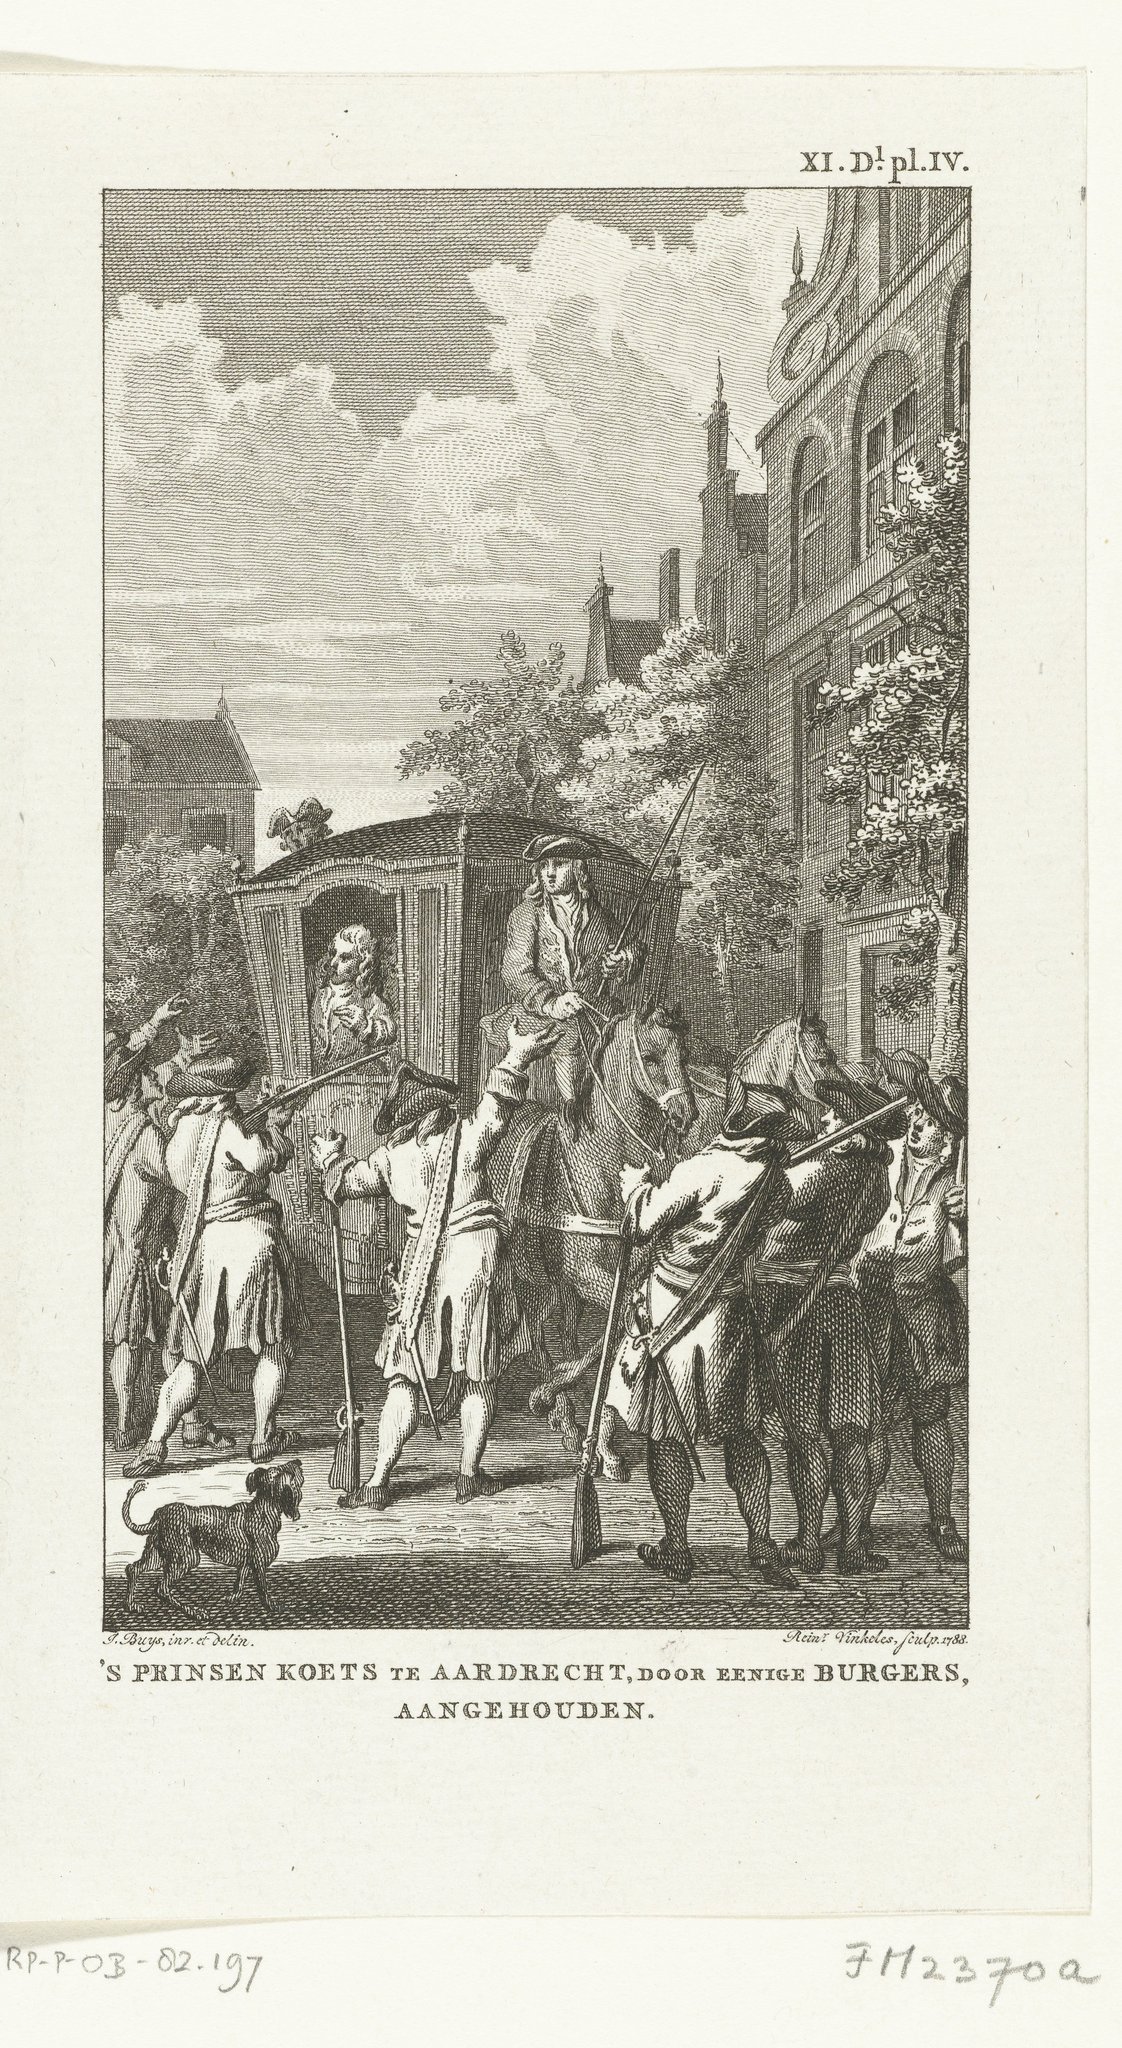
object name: history print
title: De koets van de prins aangehouden door burgers te Dordrecht, 1672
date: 1788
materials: paper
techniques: etching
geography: northern netherlands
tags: the hague, william iii (prince of orange and king of england, scotland, and ireland), dordrecht, rampjaar (disaster year)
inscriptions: date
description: Gebruikt als illustratie in: Jacobus Kok, Vaderlandsch Woordenboek, Johannes Allart, Amsterdam 1785-1799, 35 delen, dl. XI, pl. IV.